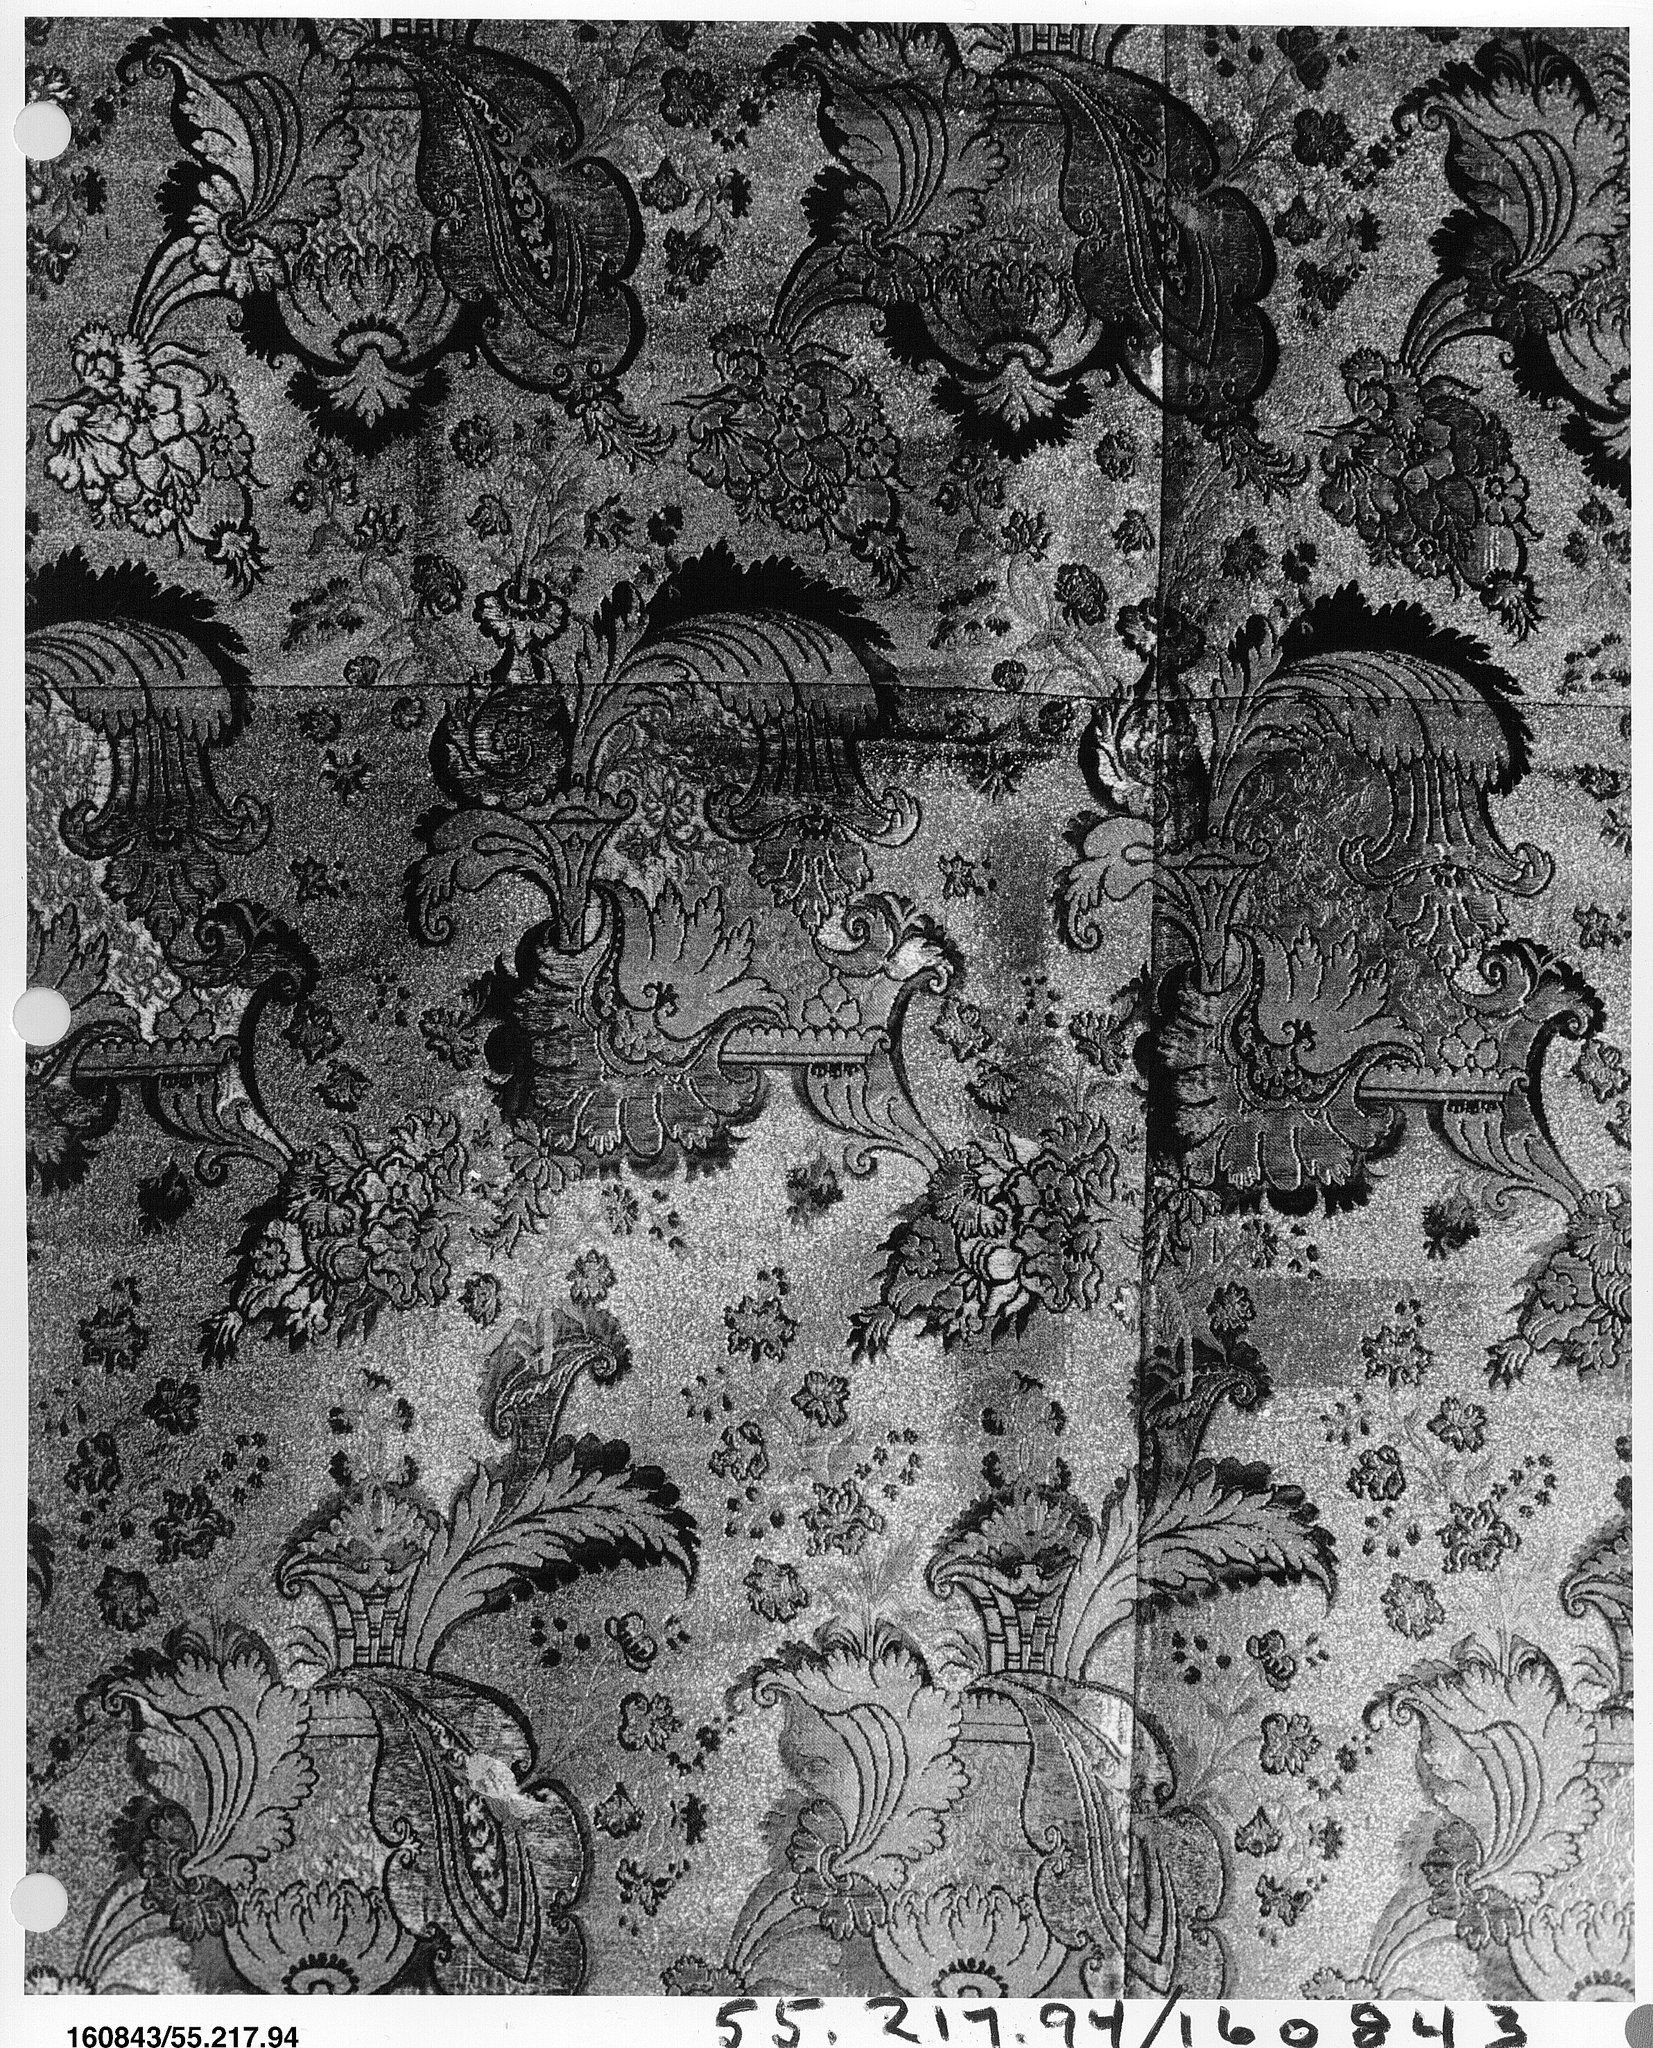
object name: piece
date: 1715-1720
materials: metal thread, silk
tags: leaves